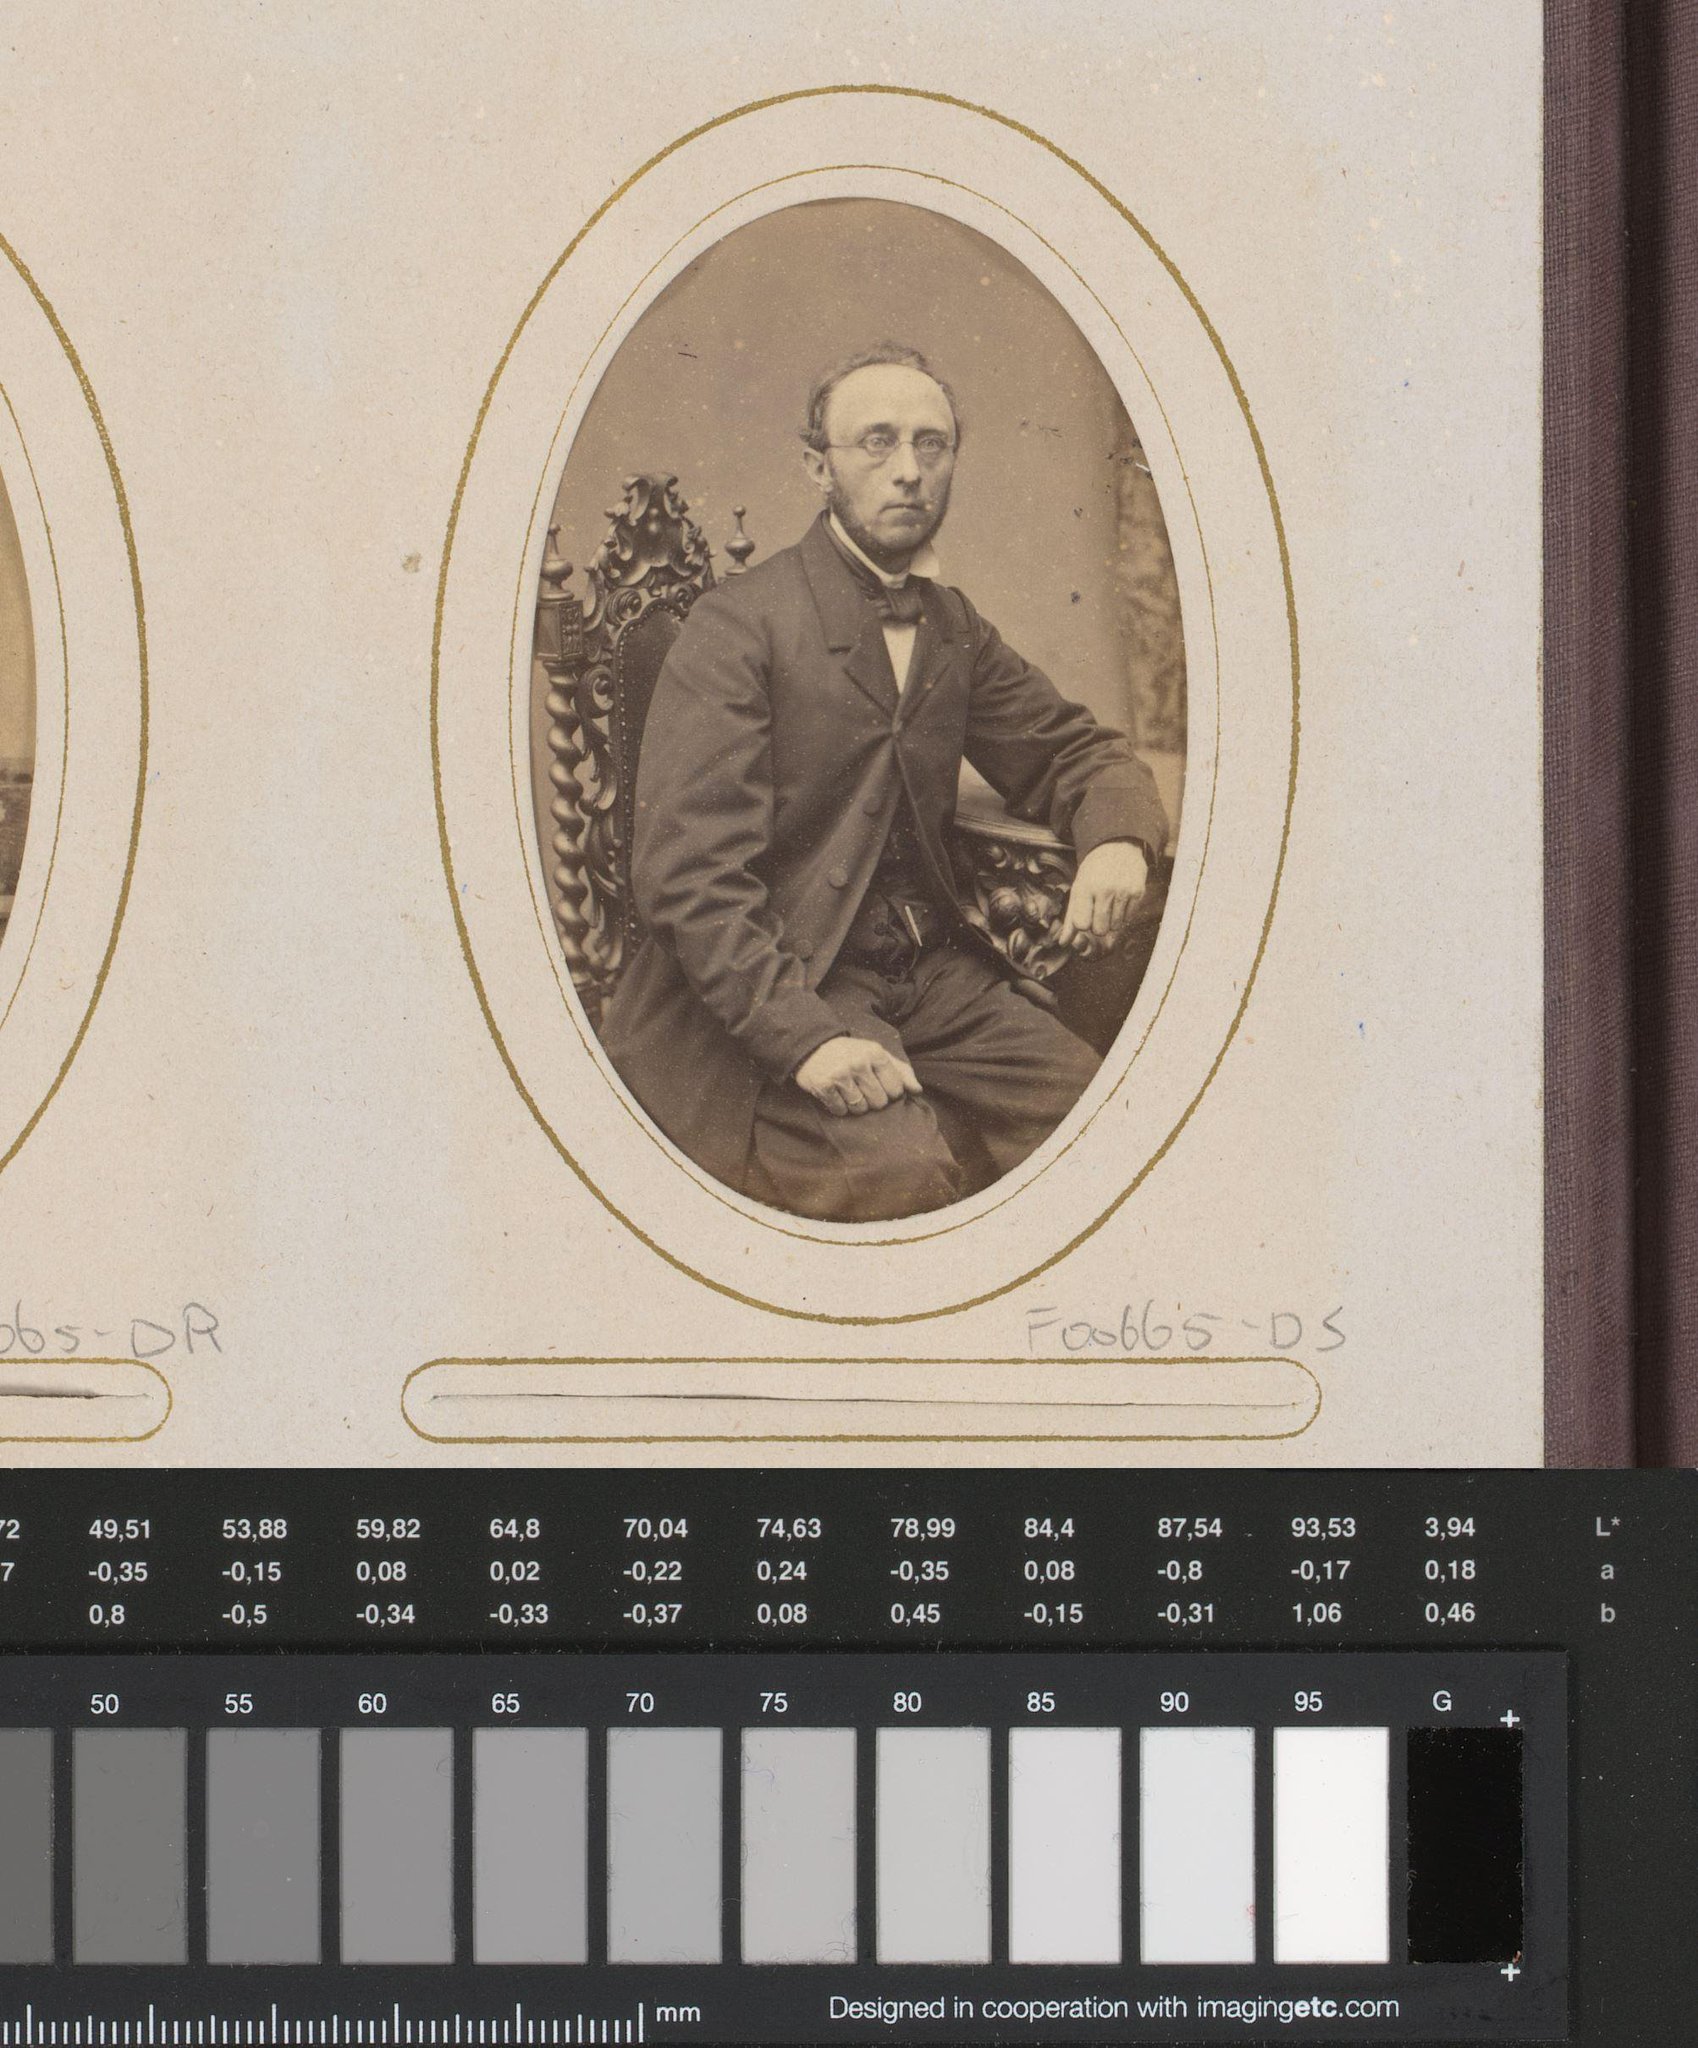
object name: carte de visite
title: Portret van een man bij een tafel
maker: albert greiner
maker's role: fotograaf, fotostudio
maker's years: 1833-1890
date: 1861-1874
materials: cardboard, photographic support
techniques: albumen print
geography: amsterdam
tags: historical persons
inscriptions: inscription: ‘A. Greiner/ photograf/ Nieuwendijk. L.87/ Amsterdam’